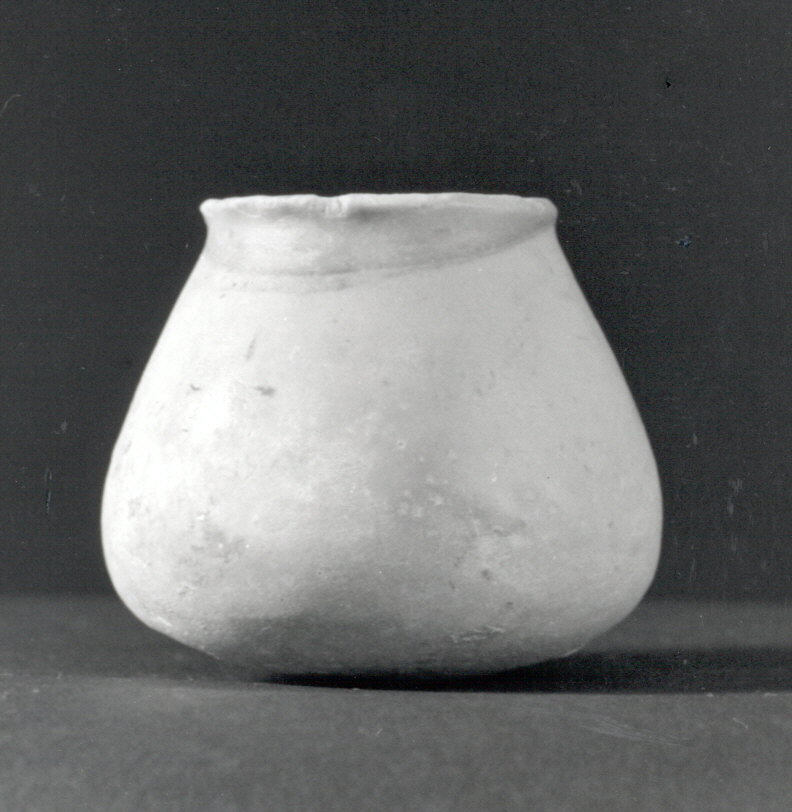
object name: jar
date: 7000-5001 BCE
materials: limestone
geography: syria